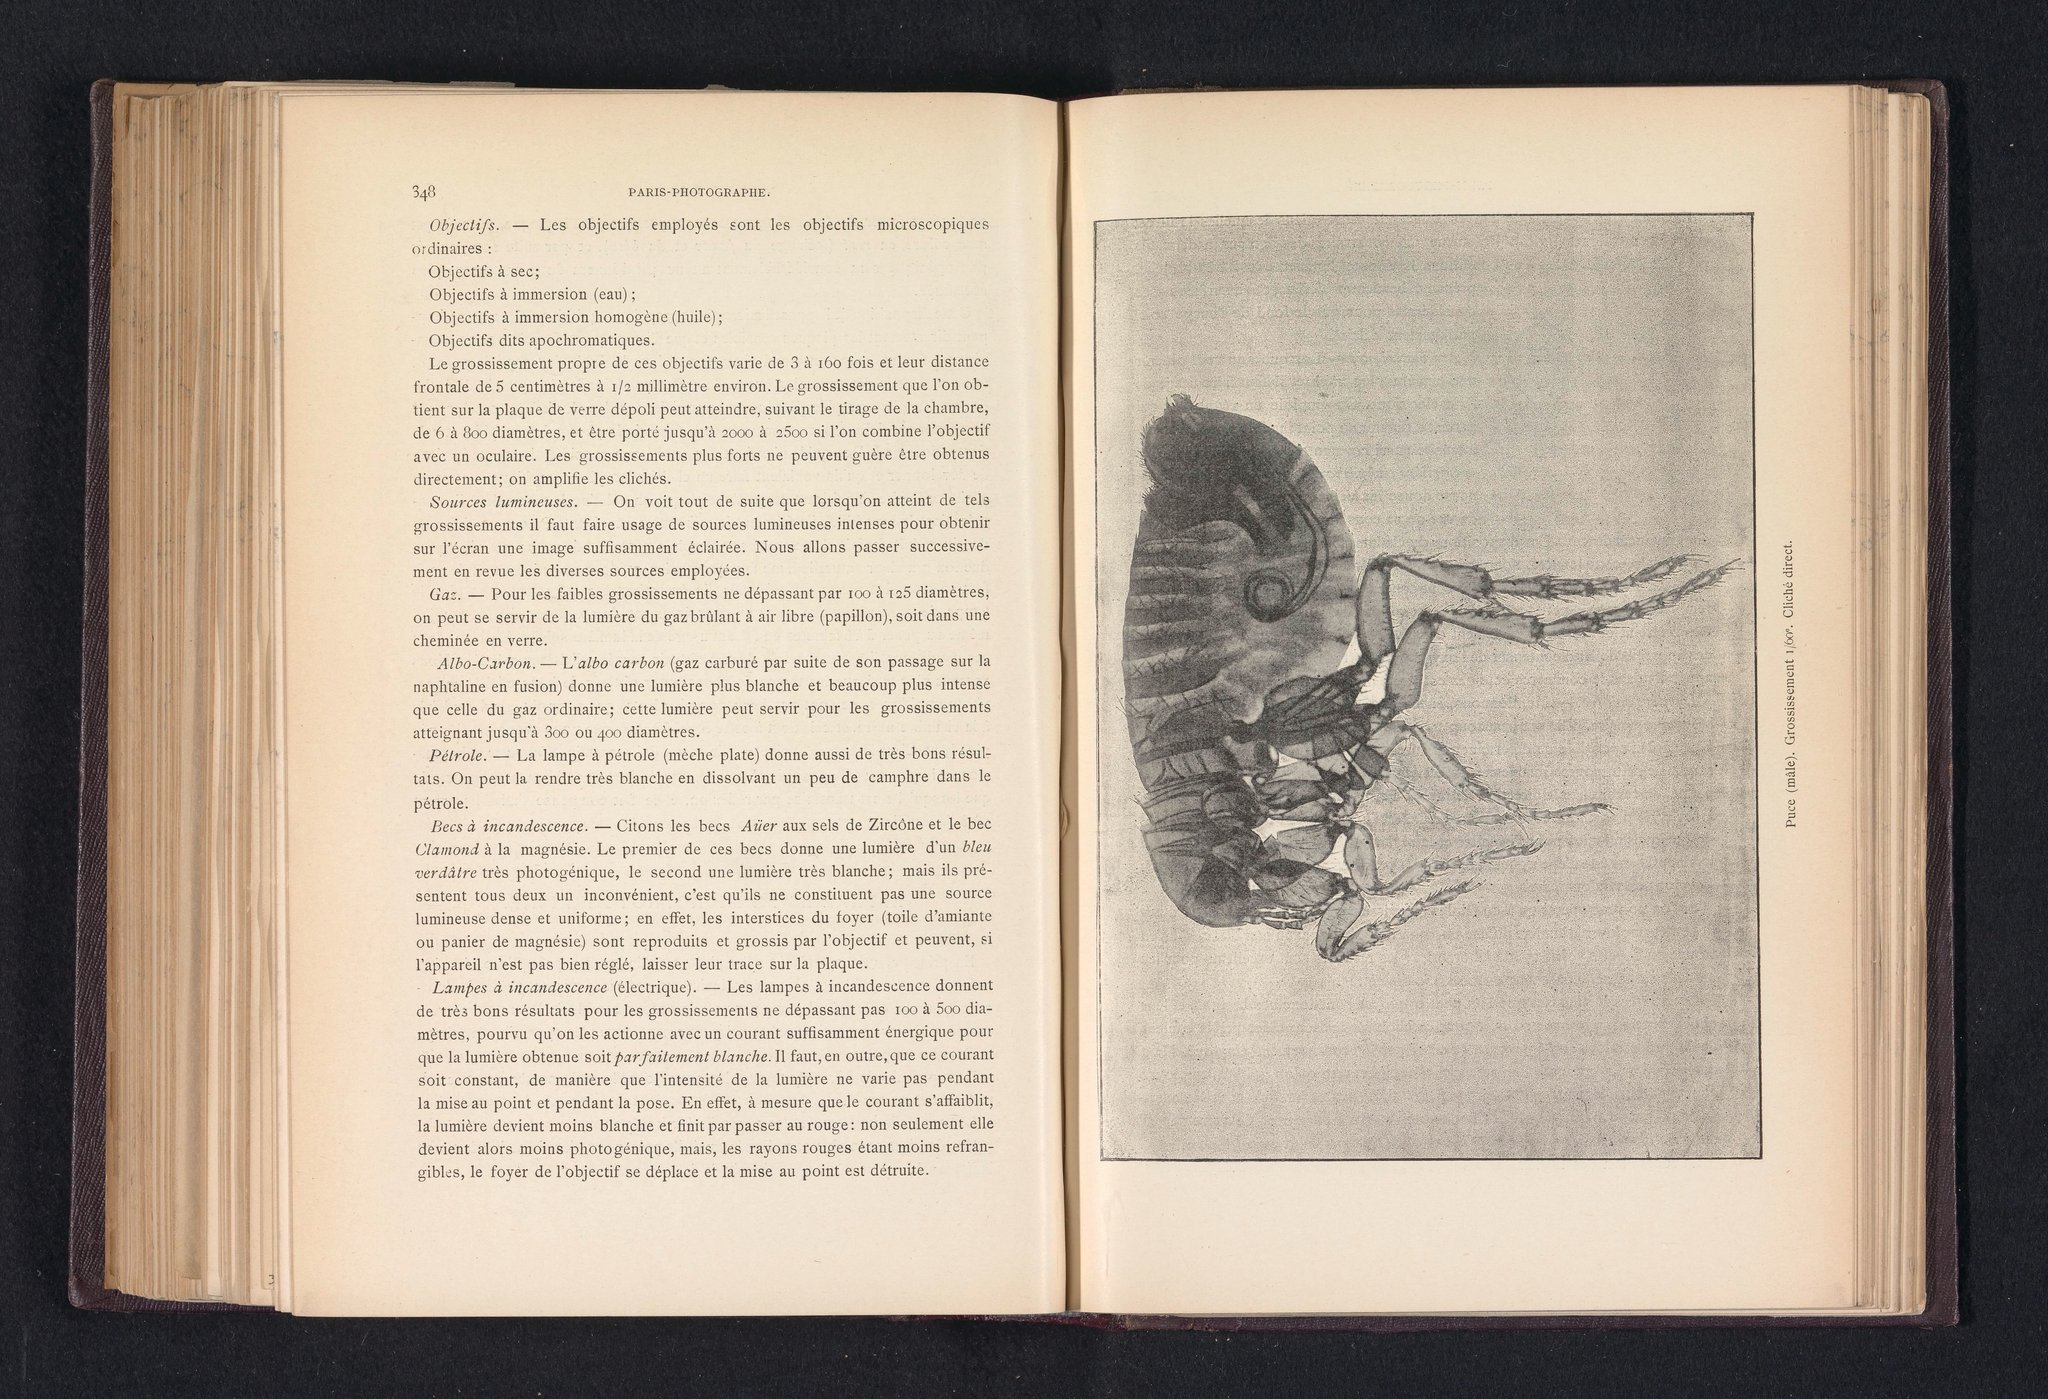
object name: page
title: Luis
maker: Anonymous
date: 1881-1891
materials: paper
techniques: autotype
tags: insects: louse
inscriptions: inscription: ‘Grossissement 1/60e. Cliché direct.’